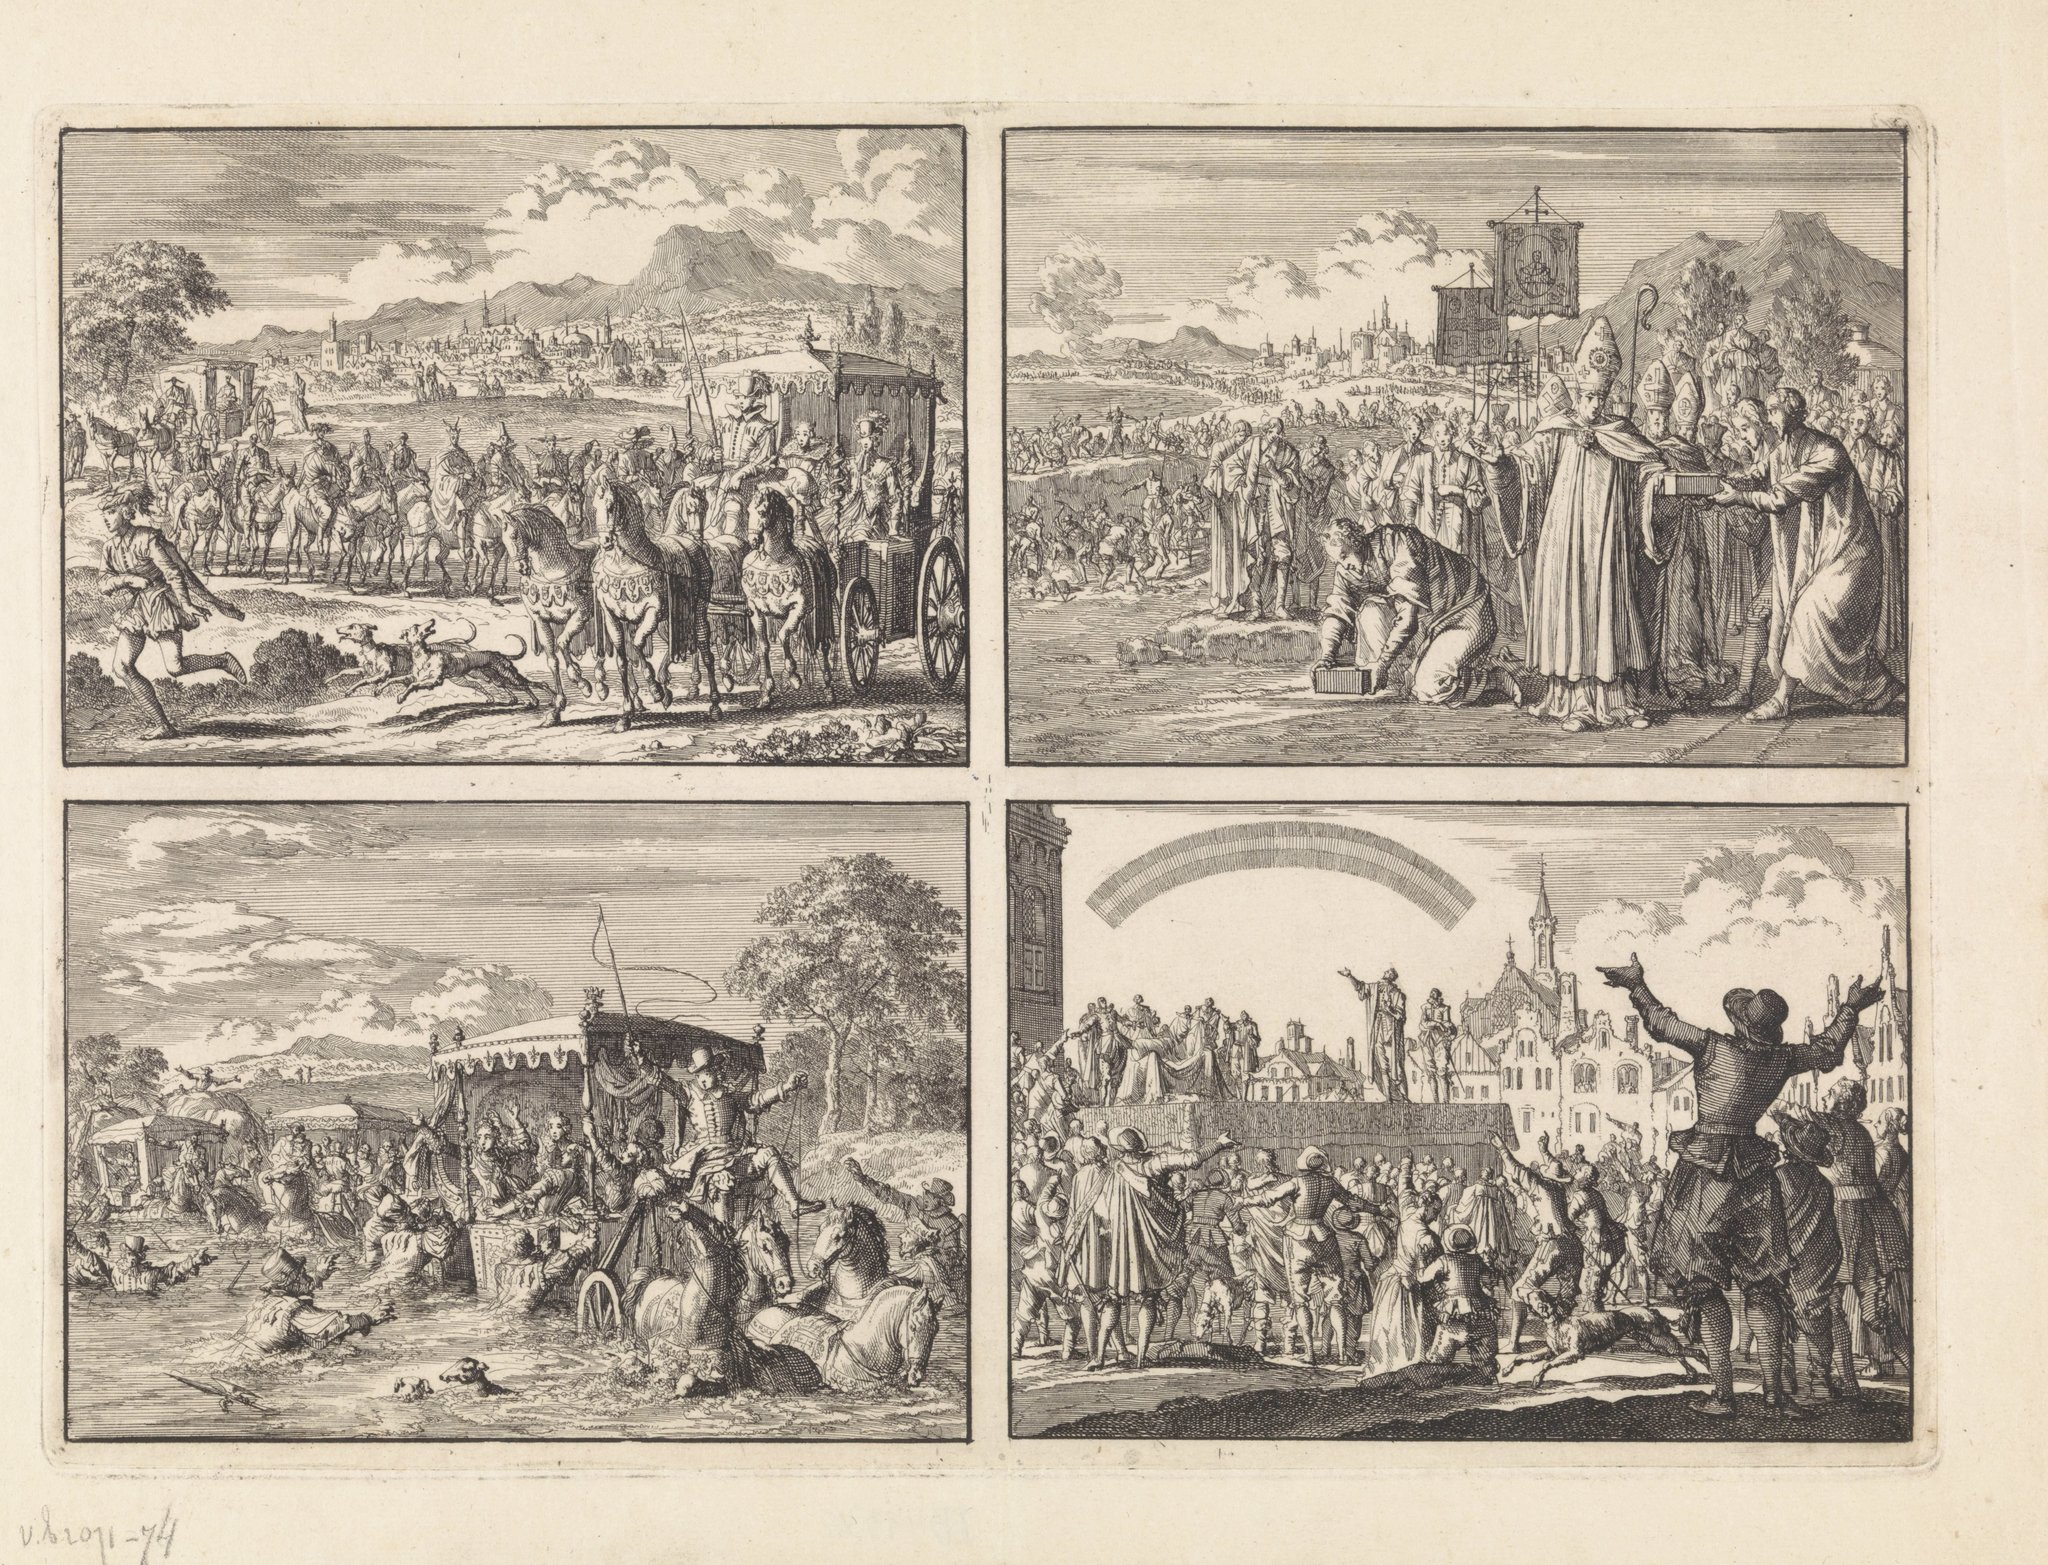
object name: print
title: Don Pedro, regent van Portugal, begeeft zich na zijn huwelijk met Maria, hertogin van Aumale, van Lissabon naar Alcantara en wordt achtervolgd door gemaskerde edelen, 1668 / Aartsbisschop van Toulouse legt de eerste steen voor de sluis in het kanaal tussen de Atlantische Oceaan en de Midellandse Zee, 1667 / Nabij Senlis raakt de stoet van koning Lodewijk XIV in levensgevaar door hoog water, 1670 / Plein te Orange, waar het bestuur van prins Willem III wordt aanvaard, terwijl de menigte kijkt naar een boog in de lucht, 1670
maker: jan luyken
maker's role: draughtsman, print maker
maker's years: 1649-1712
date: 1698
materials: paper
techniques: etching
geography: amsterdam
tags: william iii (prince of orange and king of england, scotland, and ireland), lodewijk xiv (koning van frankrijk), sluice, weir, government services, public services, rainbow (+ variant), accident with four-wheeled, animal-drawn vehicle, e.g.: cab, carriage, coach, archbishop, bishop, etc. (roman catholic), four-wheeled, animal-drawn vehicle, e.g.: cab, carriage, coach, marriage, married couple, 'matrimonium', flight, running away; pursuing, flood, village square, place (+ city(-scape) with figures, staffage)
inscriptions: collector's mark: Lugt 2228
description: Prenten gebruikt als illustratie in: Gottfried, Johann Ludwig. Historische kronyck; vervattende een (...) beschrijvingh der aldergedenckwaerdigste geschiedenissen des weerelds, van den aenvangh der scheppingh tot (...) 1576 (2 delen). Leiden: Pieter van der Aa, 1698, dl. II, p. 697, 715, 733, 737.